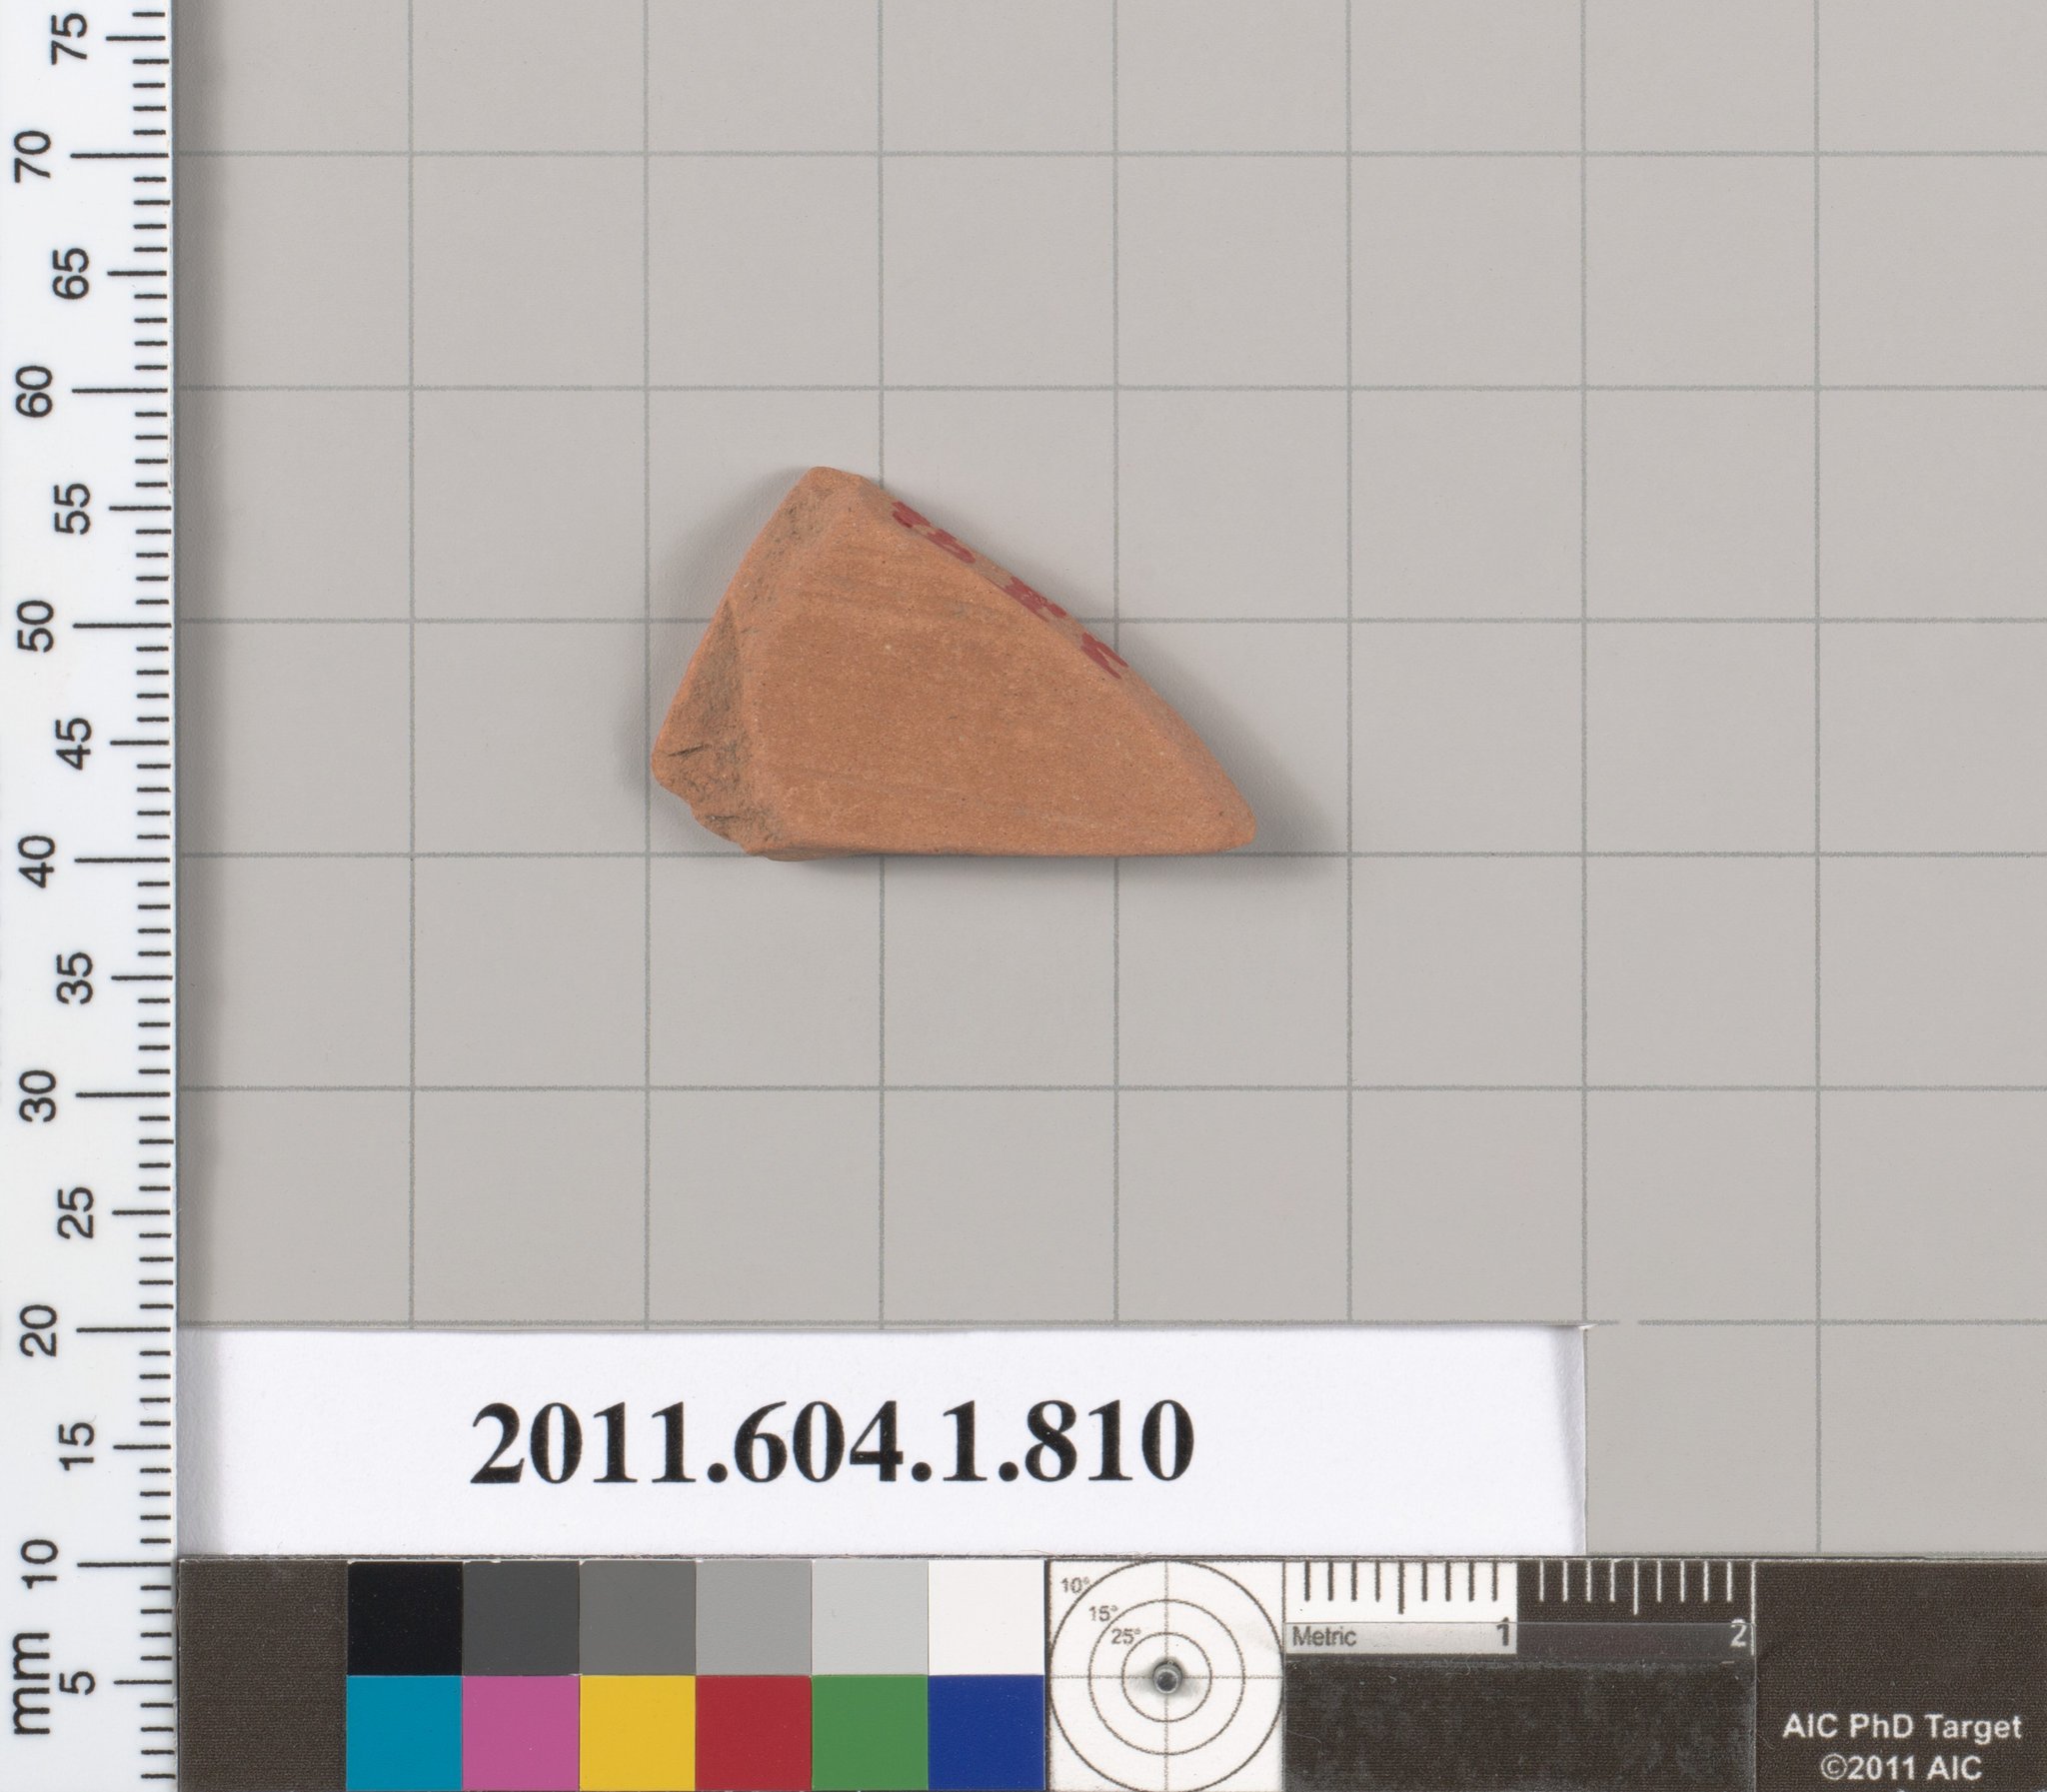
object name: kylix fragment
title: Terracotta fragment of a kylix (drinking cup)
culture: greek, attic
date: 500-401 BCE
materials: terracotta